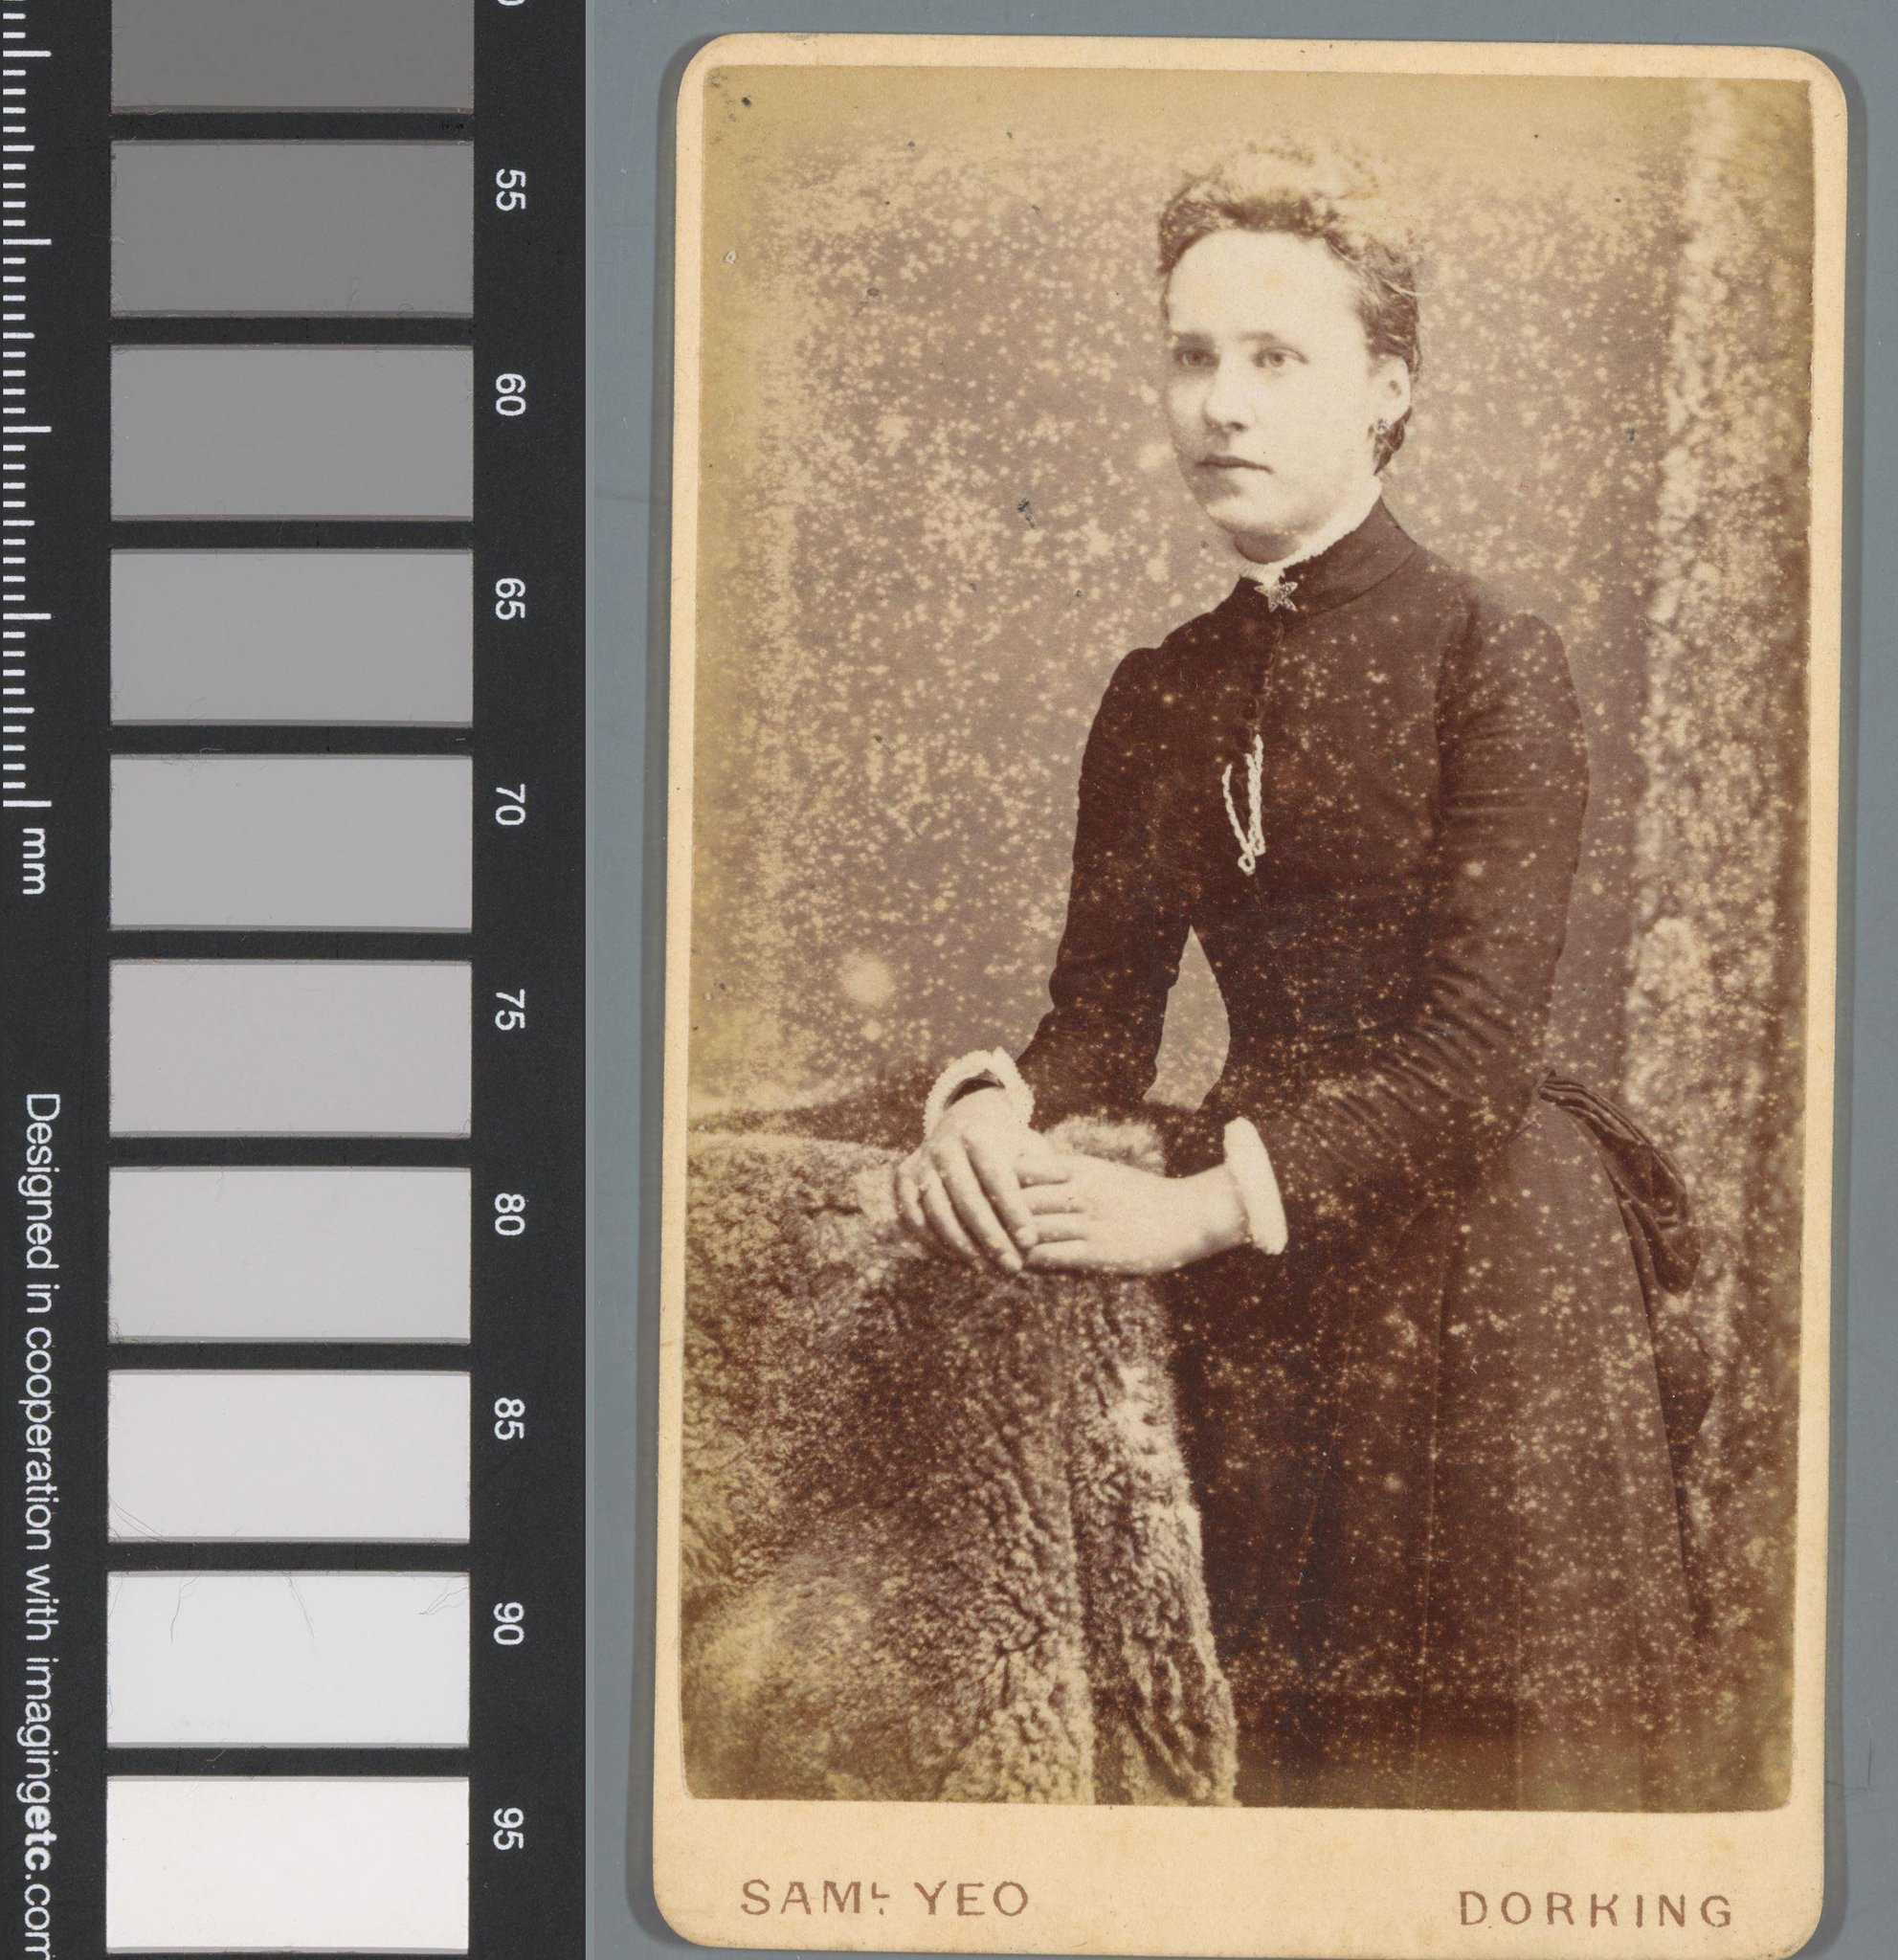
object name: photograph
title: Portret van een onbekende vrouw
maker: samuel yeo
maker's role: fotograaf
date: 1880-1900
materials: cardboard, paper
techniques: albumen print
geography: dorking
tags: historical persons - bb - woman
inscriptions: inscription: ‘THE DORKING STUDIO/ 54, High Street/ DORKING/ SAML. YEO/ PORTRAIT/ GROUP & ARCHITECTURAL/ PHOTOGRAPHER/ SPECIALITY/ PORTRAITS ON/ PORCELAIN/ Extra Copies of this Picture/ can be had at any time’